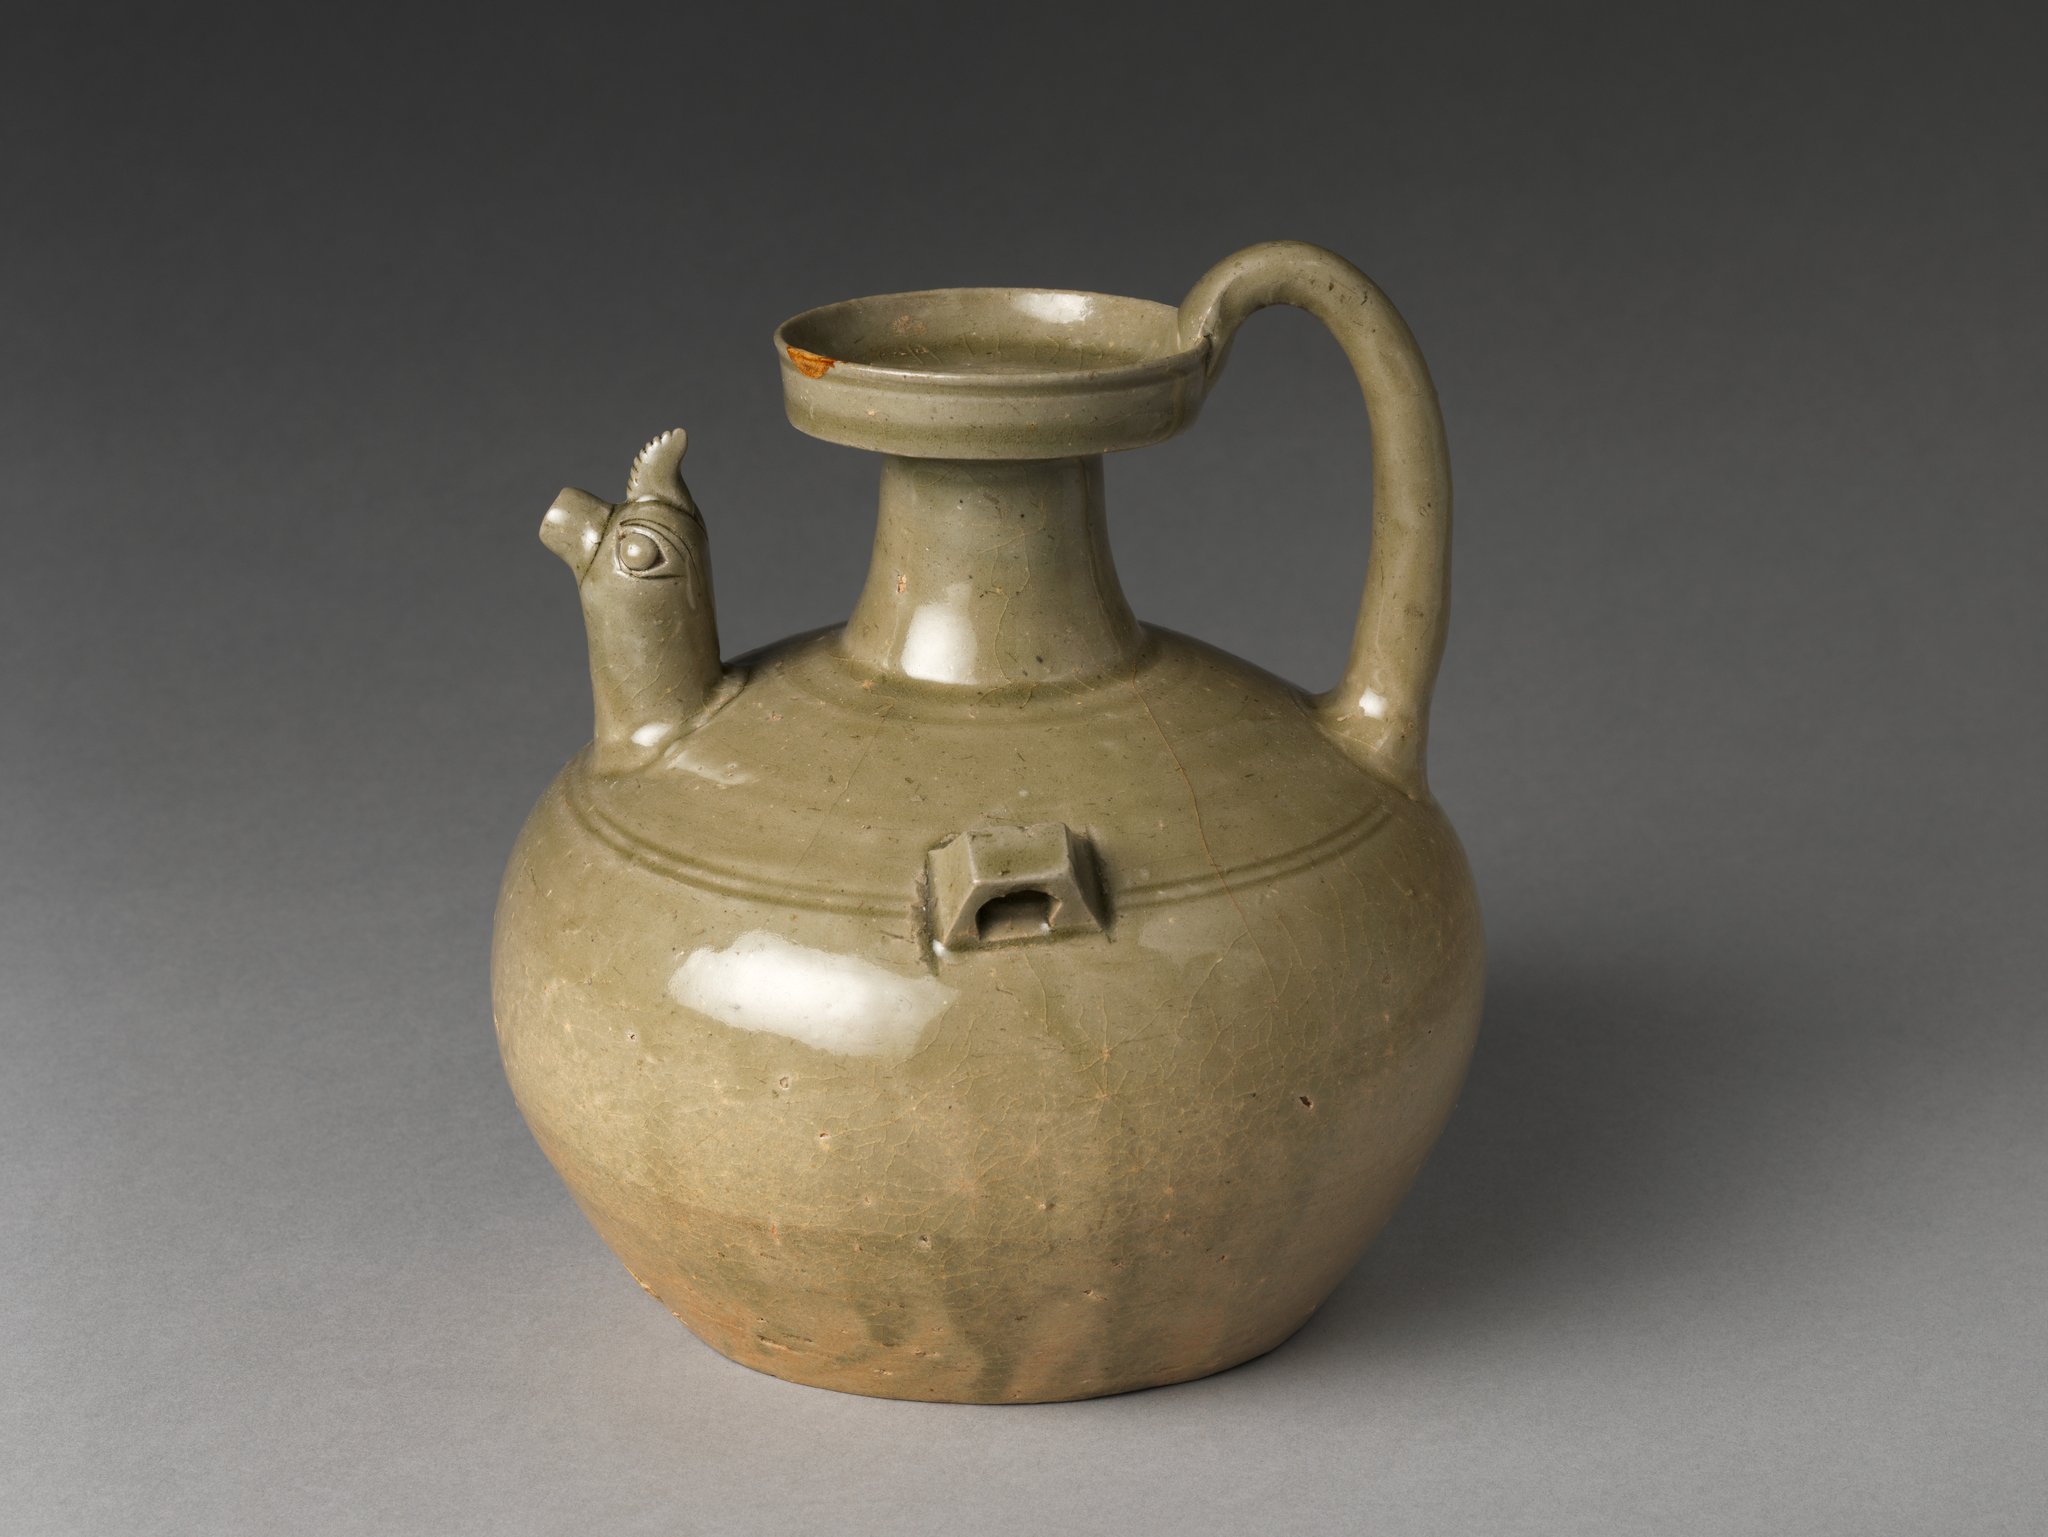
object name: ewer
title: Chicken-Headed Ewer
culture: chinese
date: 301-500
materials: ceramic glaze, glaze, stoneware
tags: chickens